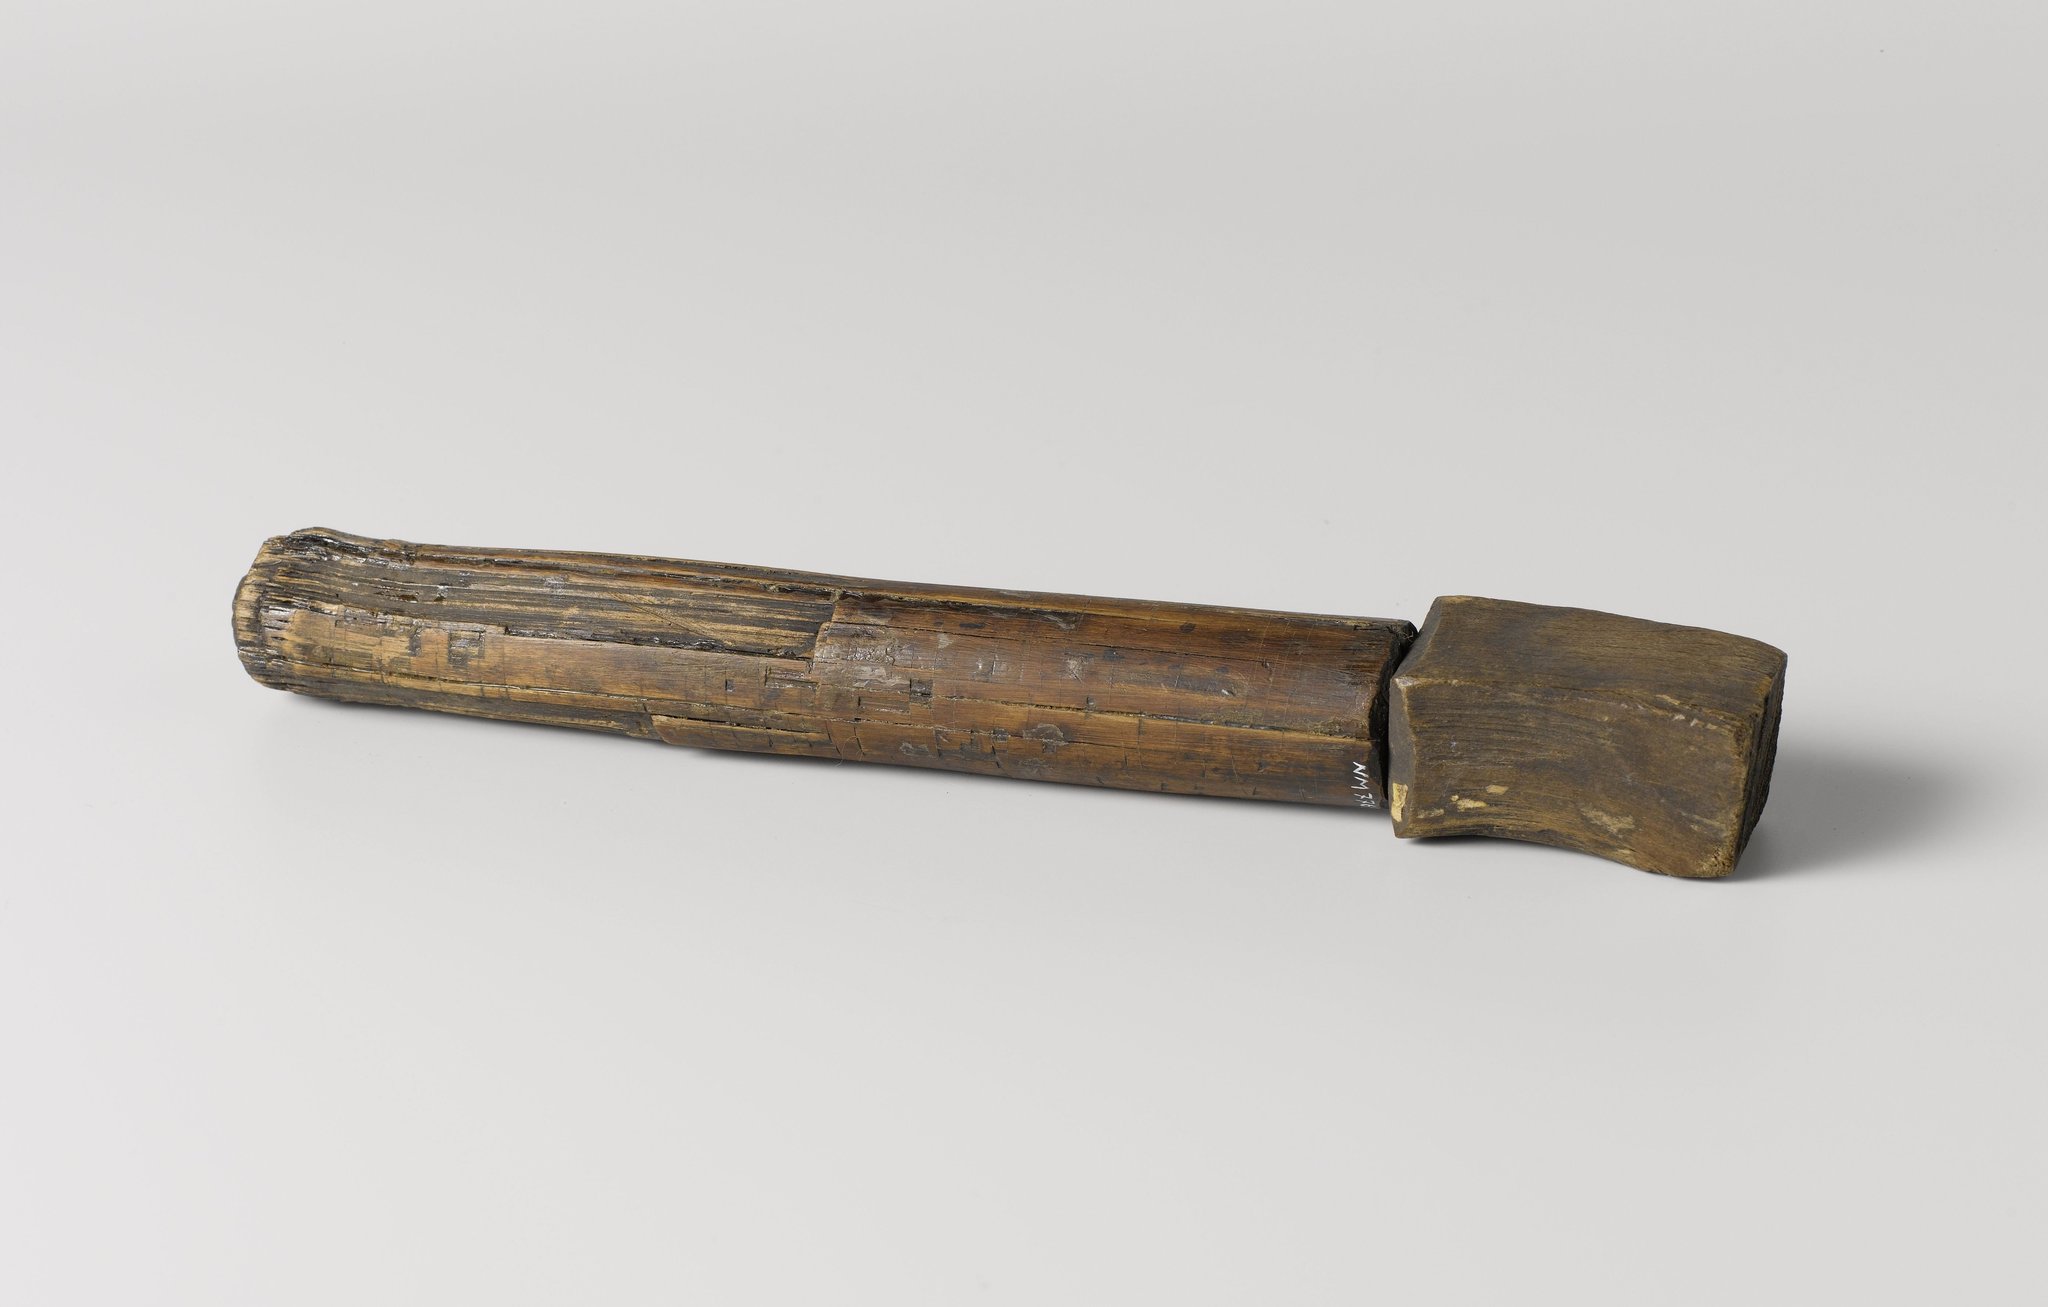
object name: patroonvorm, patroonmal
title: Holle buis van hout, onderdeel van patroonvorm met bijpassende patroonmal van hout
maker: Anonymous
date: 1590-1596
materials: wood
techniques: cutting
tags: willem barendsz., amsterdam, jacob van heemskerck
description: Holle houten buis, onderdeel van patroonvorm met bijpassende patroonmal van hout. Beschrijving NM-7769-1 en NM-7769-2. De mal diende om een papieren patroon te maken waarin de lading buskruit en de kogel voor een schot konden worden geprepareerd. Kruit en kogel werden door middel van een draad gefixeerd. De schutter hoefde om zijn vuurwapen te laden niet meer te doen dan de onderkant van de patroon af te bijten en de patroon met kogel en al in de loop van zijn wapen te stampen. De militaire musket werd in het gevecht niet met zoveel voorzorg geladen, de kogel ging los in de loop, eventueel omwonden met een lapje of een stuk papier. Wilde men raak schieten over enige afstand dan was zorgvuldig laden nodig, vandaar vermoedelijk de aanwezigheid van dit apparaat in het Behouden Huys.